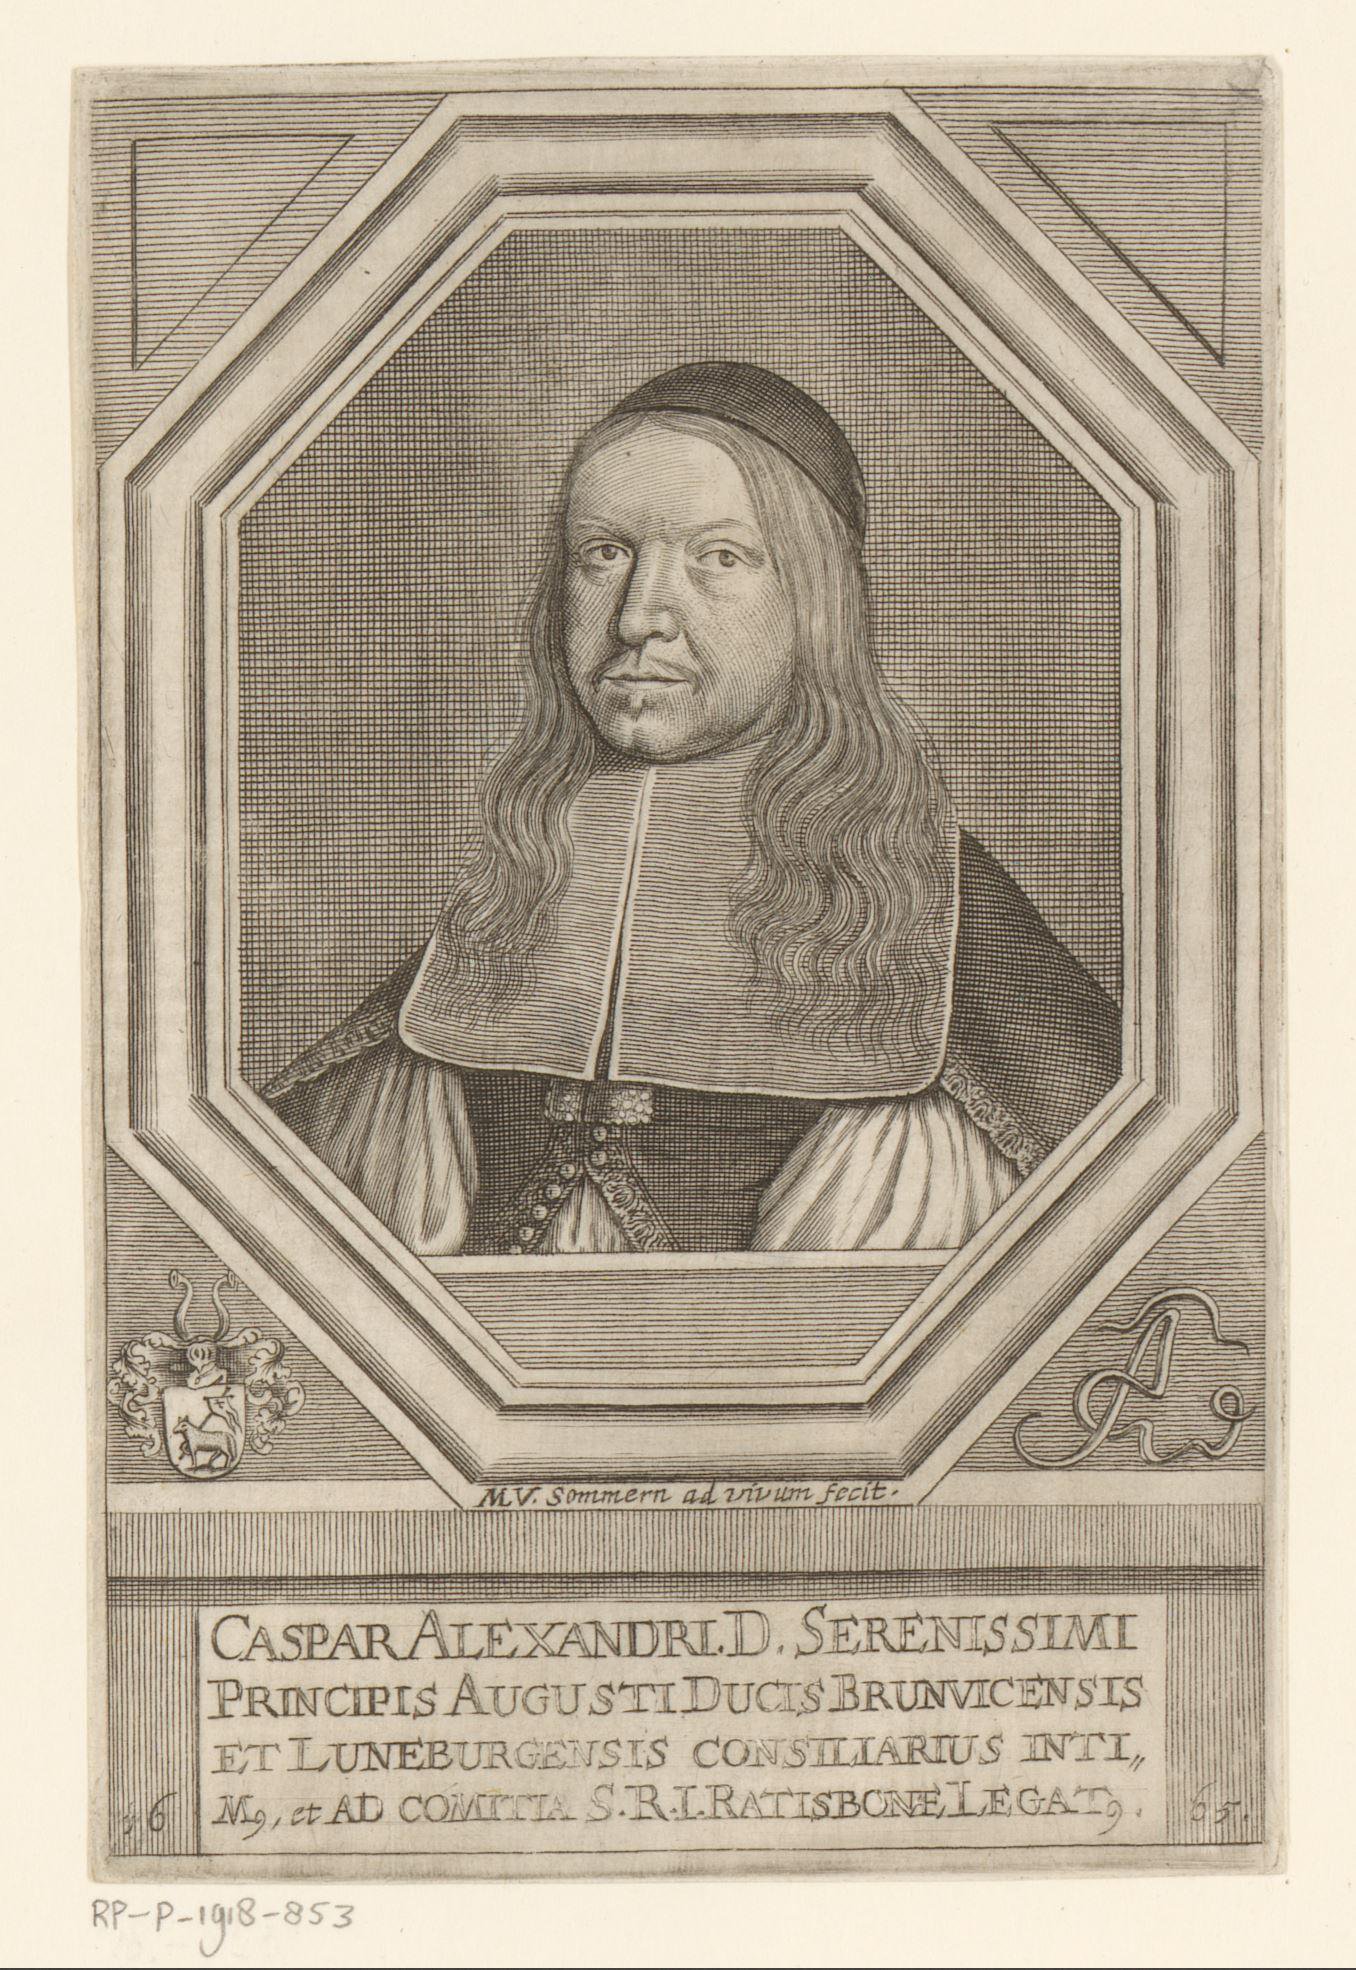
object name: print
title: Portret van Caspar Alexandri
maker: matthias van sommer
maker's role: draughtsman, print maker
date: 1665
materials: paper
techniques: engraving, etching, intaglio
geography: germany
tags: historical persons, armorial bearing, heraldry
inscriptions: collector's mark: Lugt 2228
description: Volgens Hollstein werd de prent gebruikt voor de publicatie: Sommer, Matthias van. Hasce Omnium Electorum. Regensburg: s.n., 1667. Alhoewel op de titelpagina van de publicatie het jaar 1667 wordt vermeld, zijn meerdere prenten later gedateerd. Waarschijnlijk werd de publicatie pas in 1671 daadwerkelijk uitgegeven.